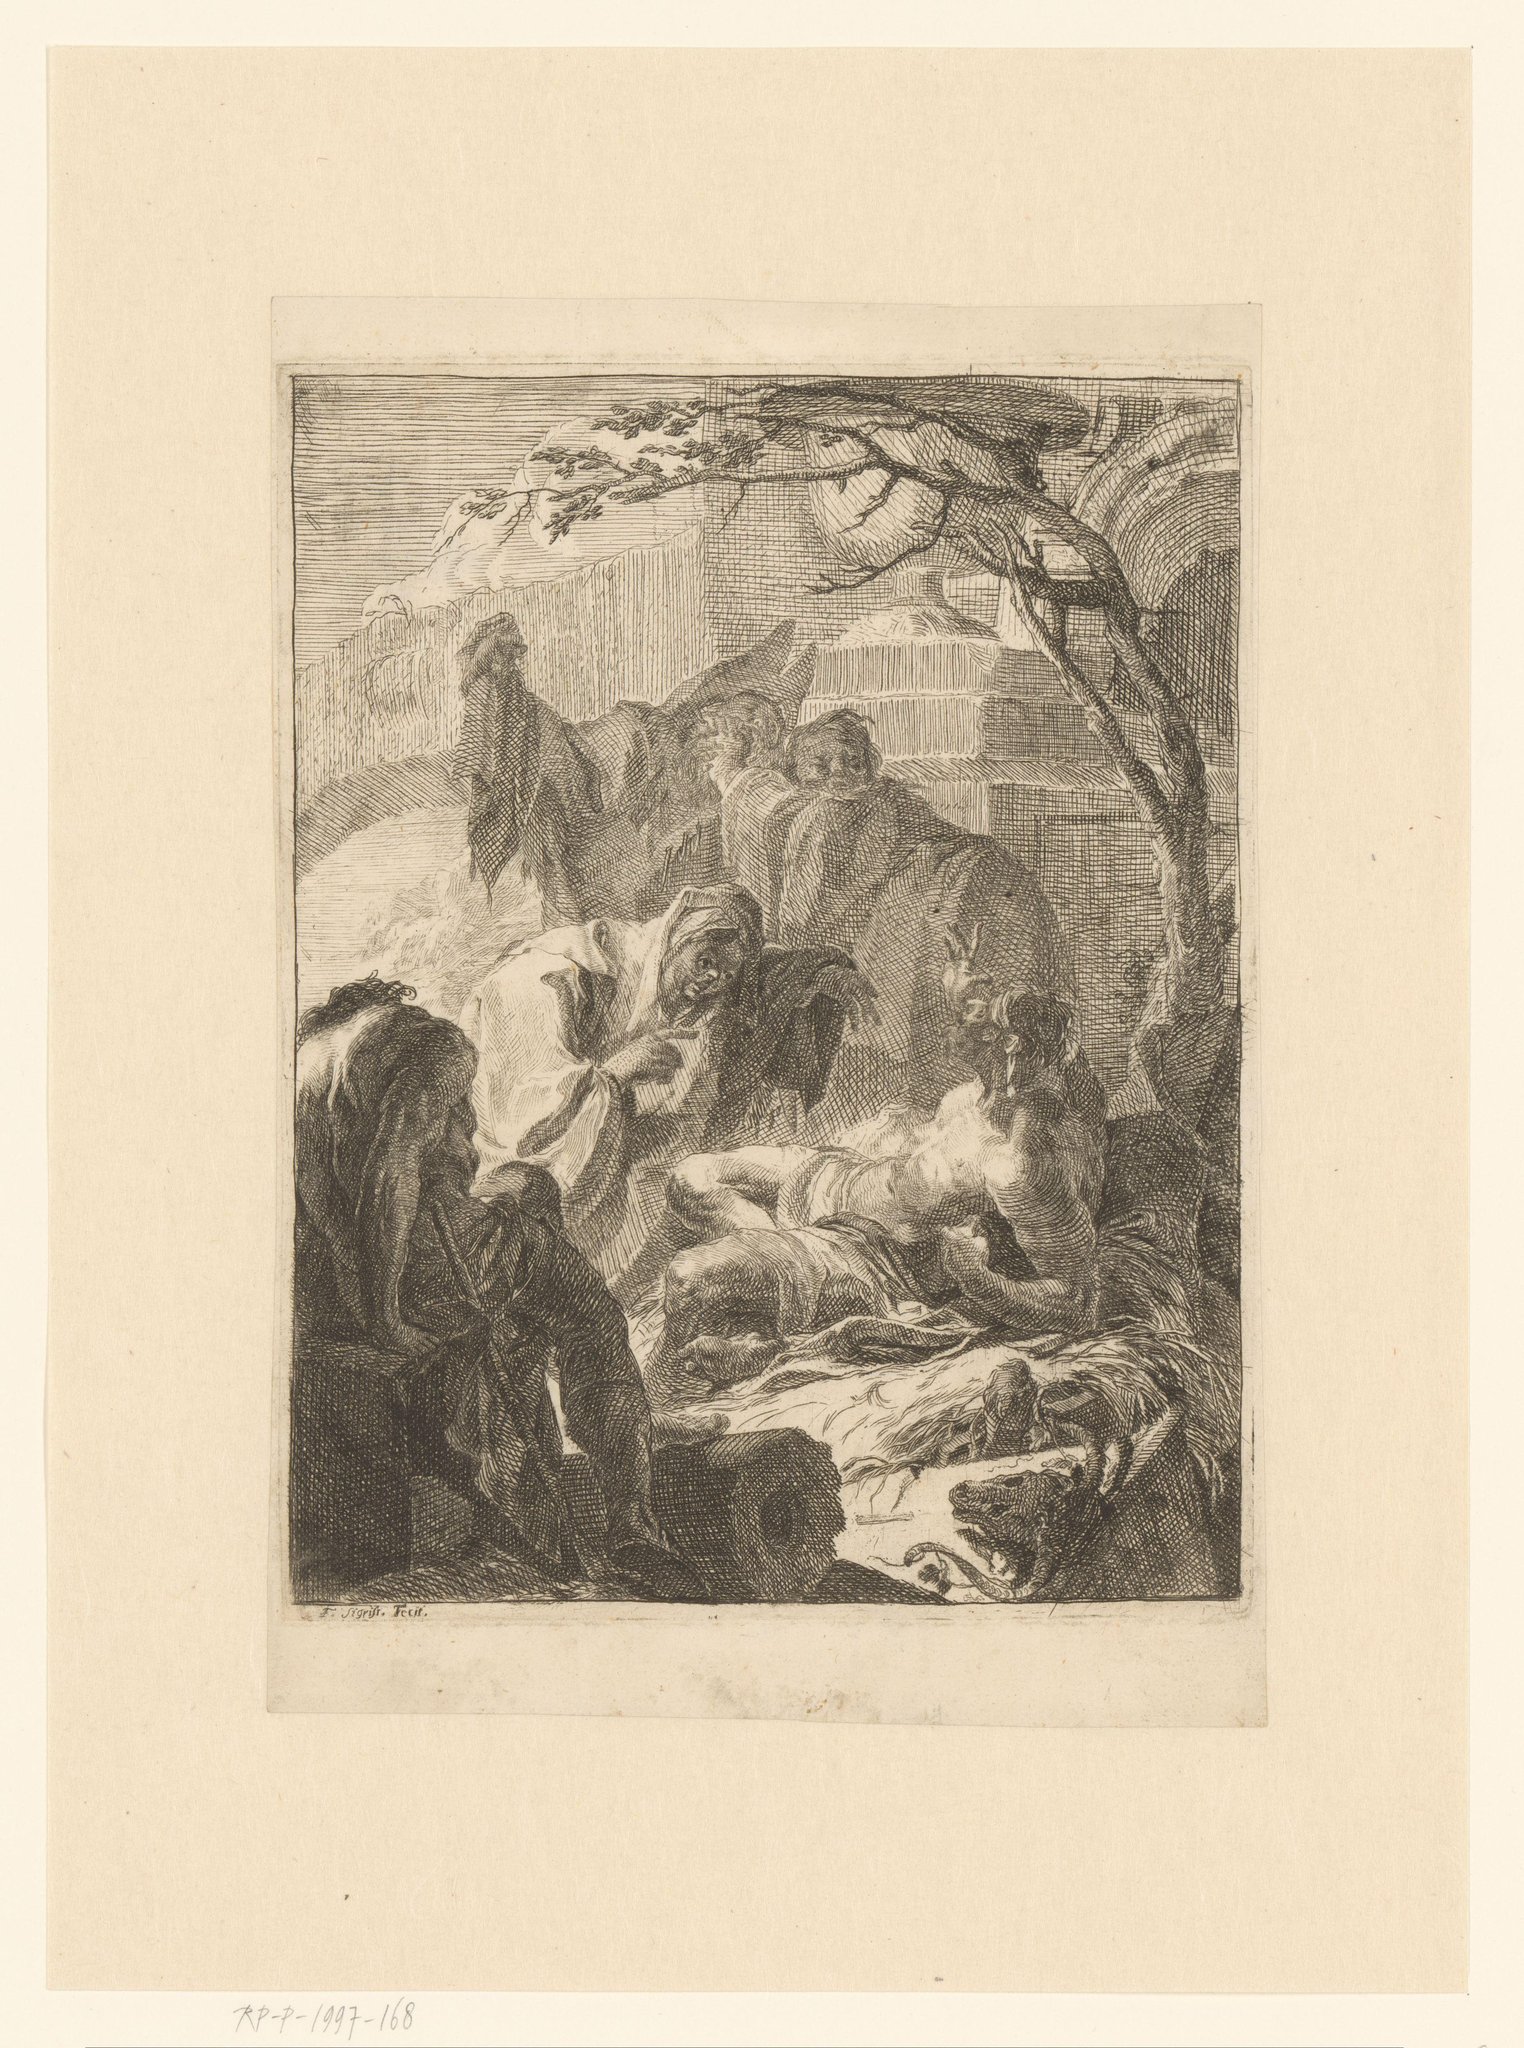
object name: print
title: Bespotting van Job op de mestvaalt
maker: franz sigrist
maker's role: print maker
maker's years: 1727-1803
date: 1752-1753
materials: paper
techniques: drypoint, etching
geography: germany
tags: job on the dunghill (job 2:7-13)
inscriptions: collector's mark: ‘Görgey Magyatek Szam’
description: Job op de mestvaalt, onder een boom. Voor hem staan drie figuren die hem bespotten. Links een zittende figuur.